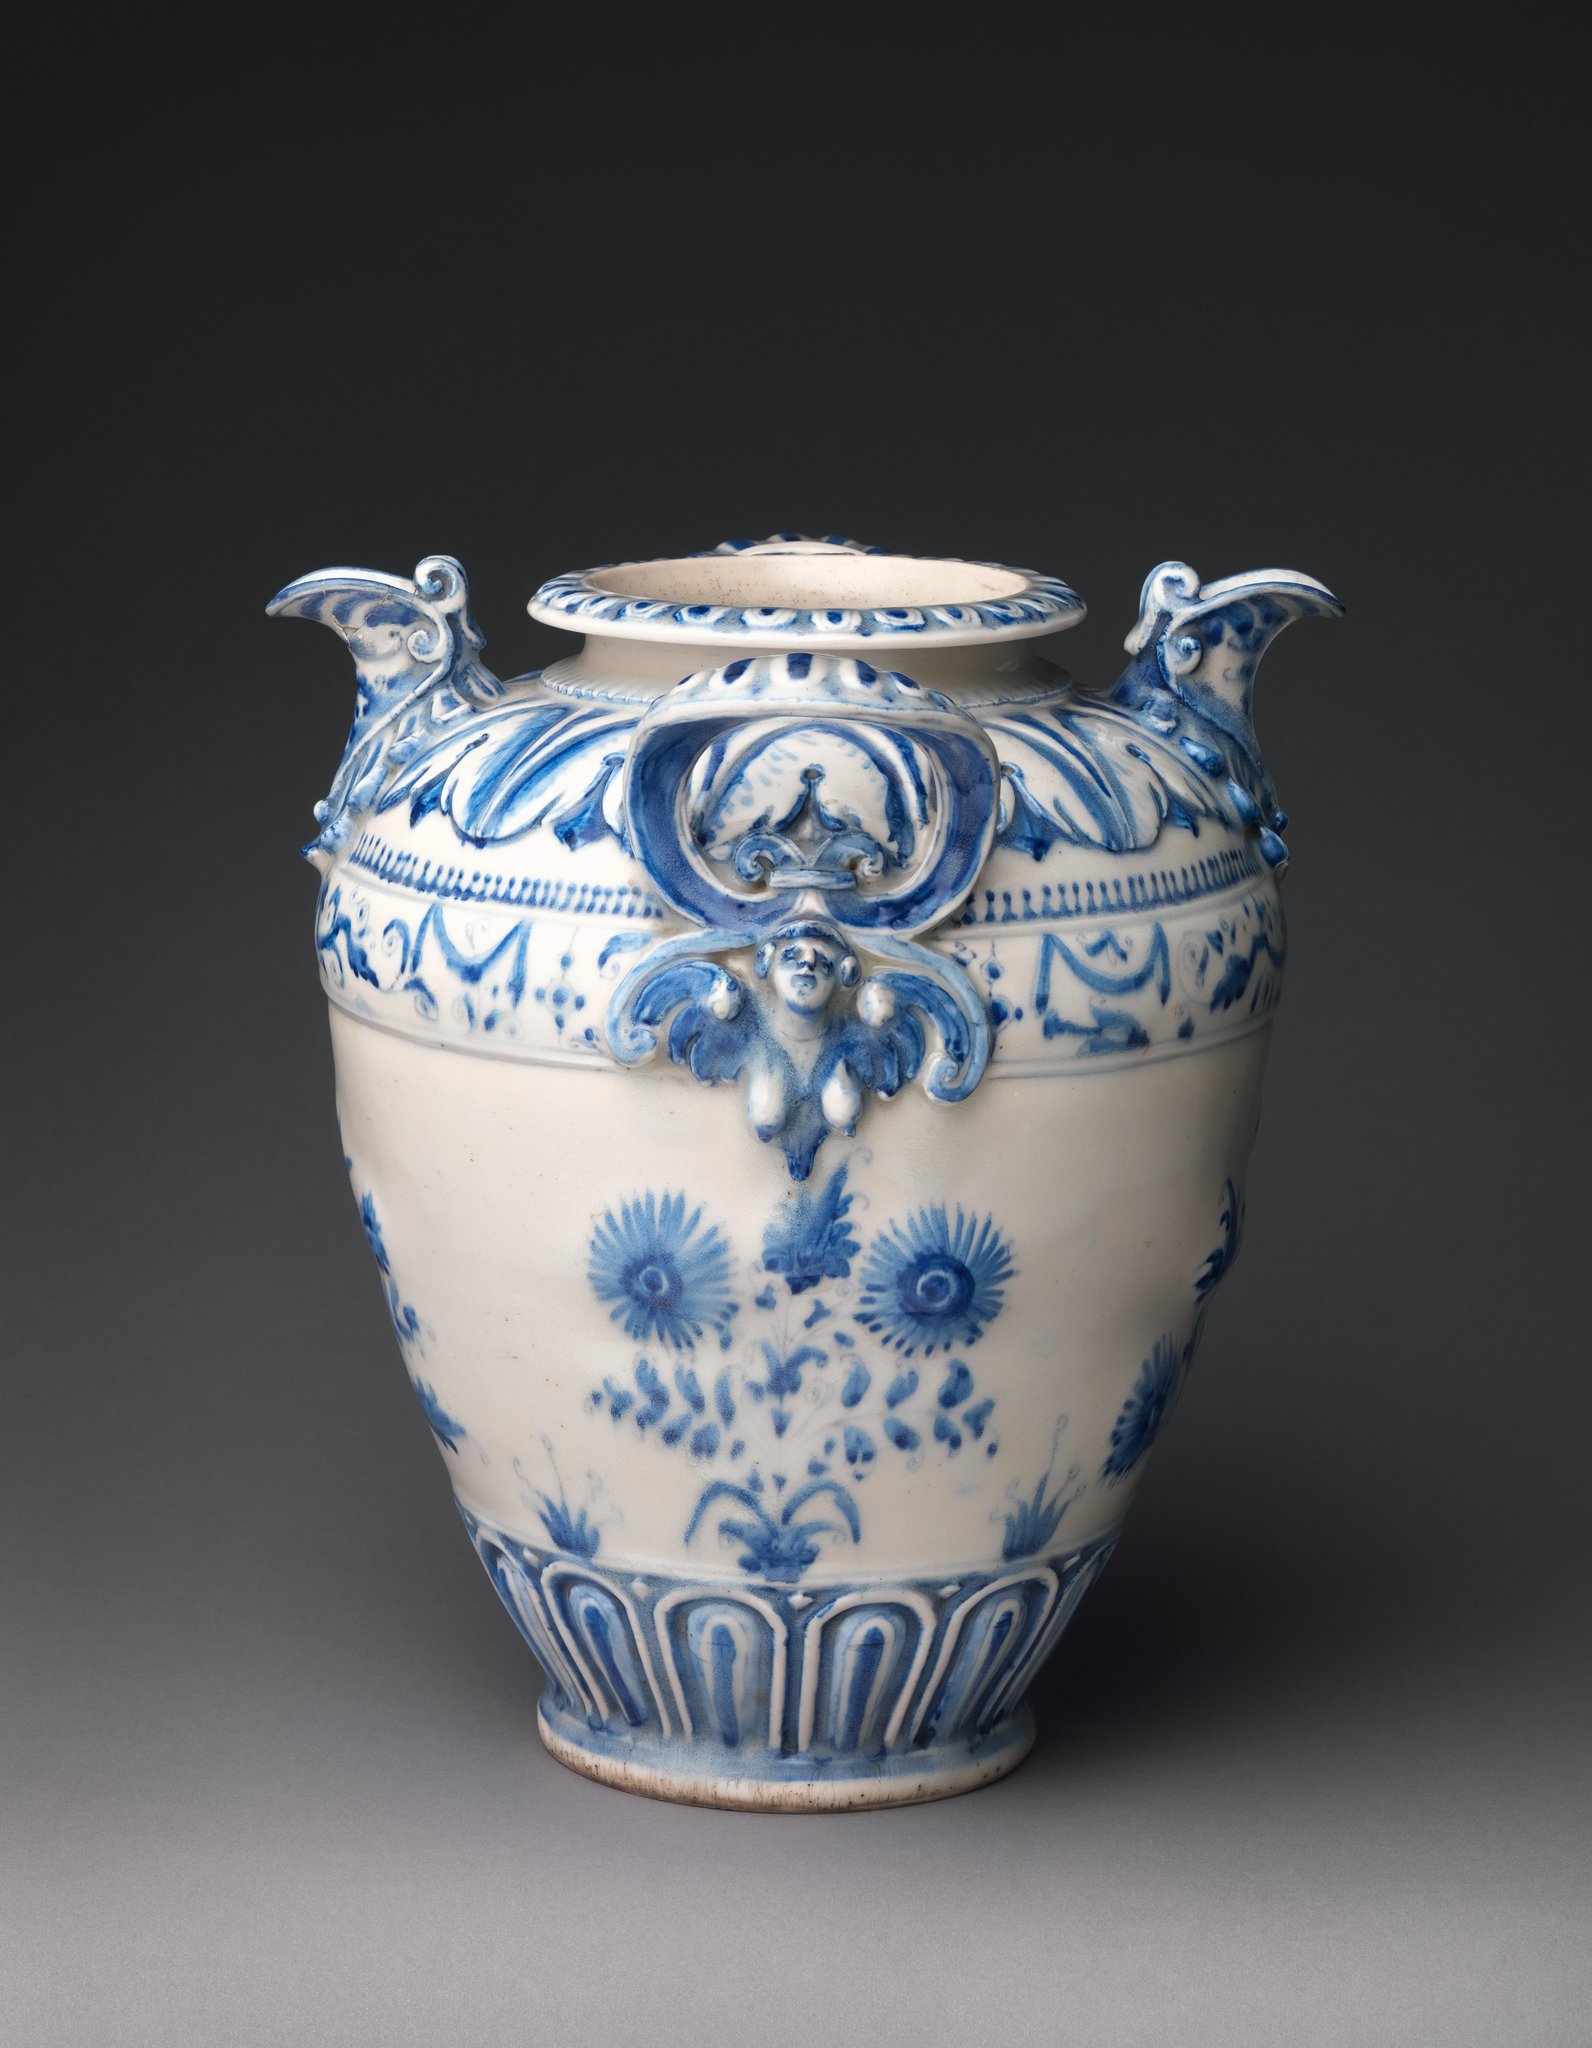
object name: ewer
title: Ewer (Brocca)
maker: medici porcelain manufactory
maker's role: manufactory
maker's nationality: italian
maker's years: 1570-1592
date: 1575-1580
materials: soft paste porcelain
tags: flowers